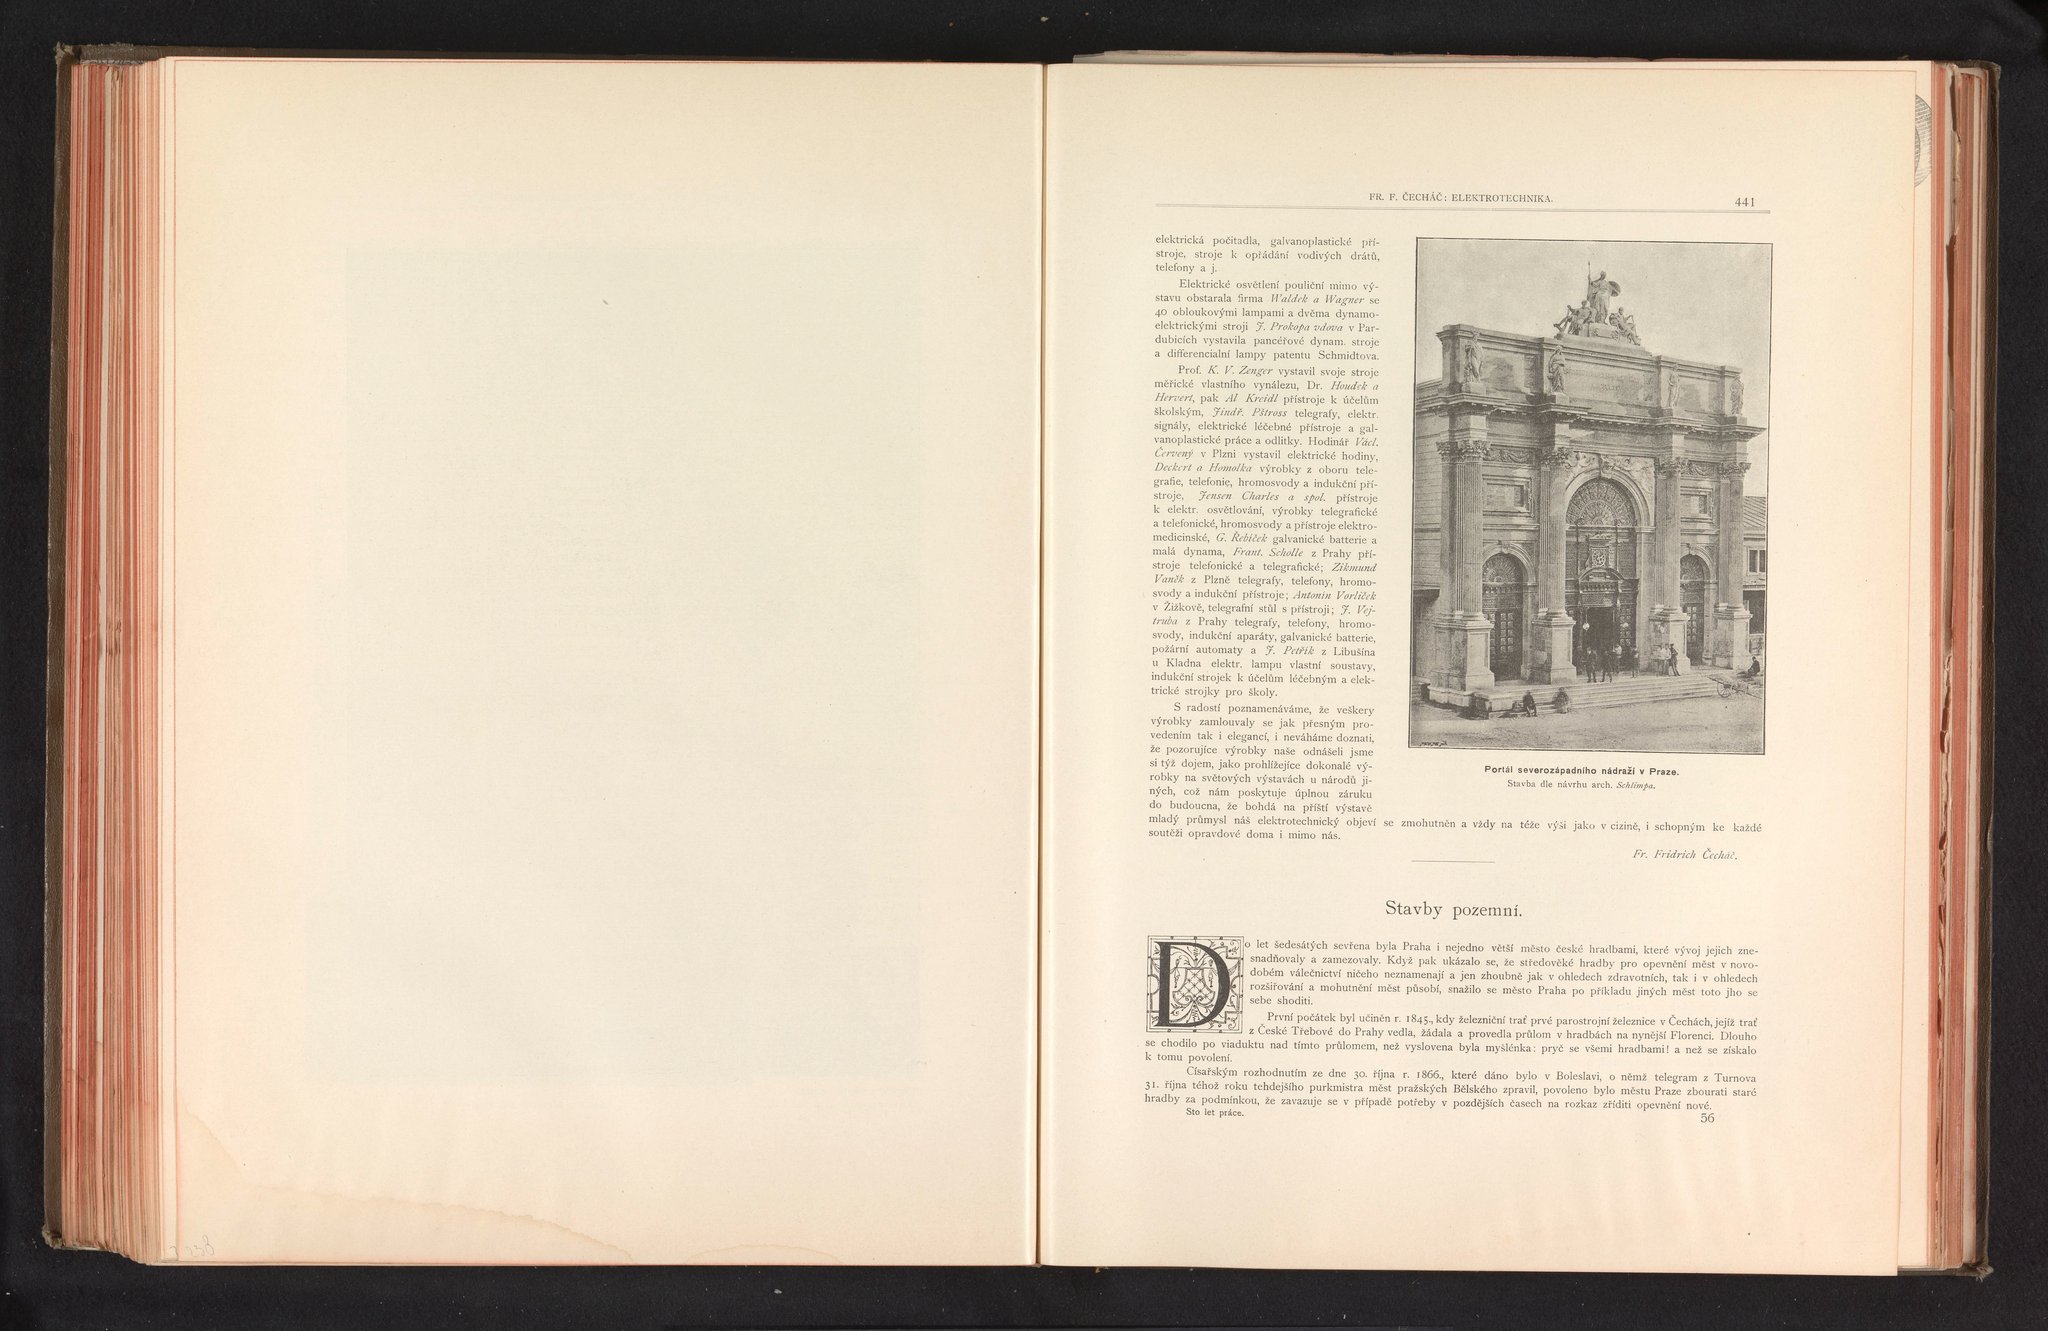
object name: photomechanical print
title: Portál severozápadního nádrazi v Praze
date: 1891-1895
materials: paper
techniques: autotype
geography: prague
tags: façade (of house or building), station; shelter (railway, tramway)